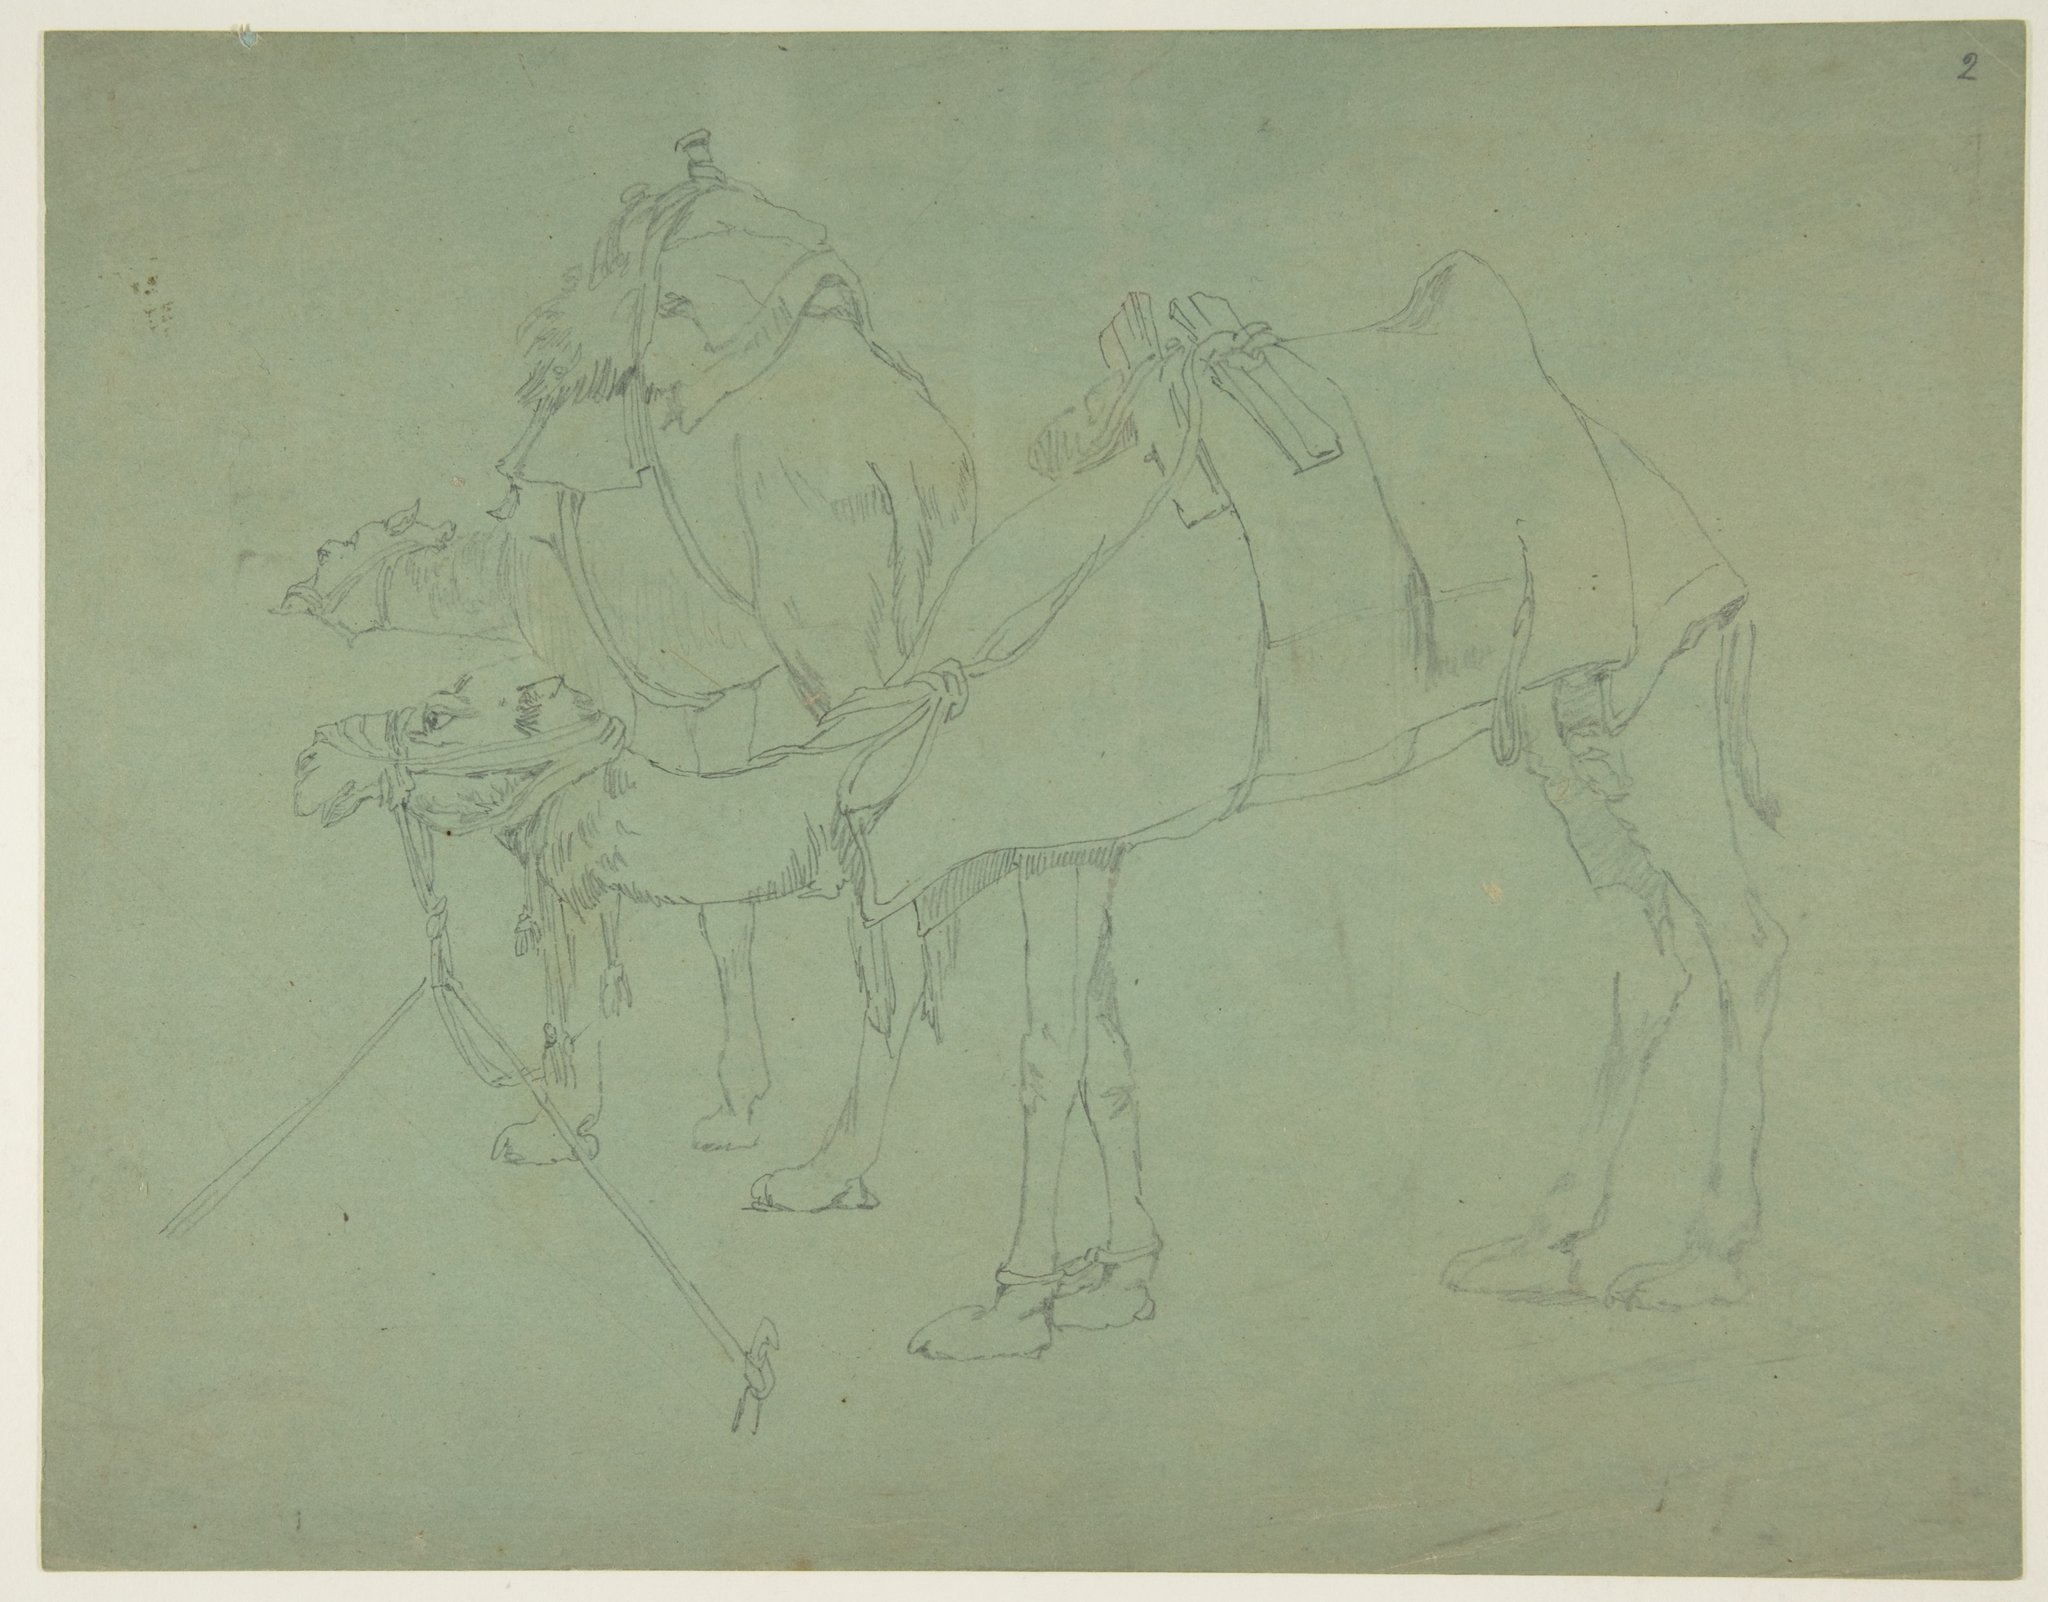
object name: drawing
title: Two Camels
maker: anonymous, french, 19th century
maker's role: artist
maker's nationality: french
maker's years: 1800-1900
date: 1801-1900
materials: graphite, paper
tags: camels